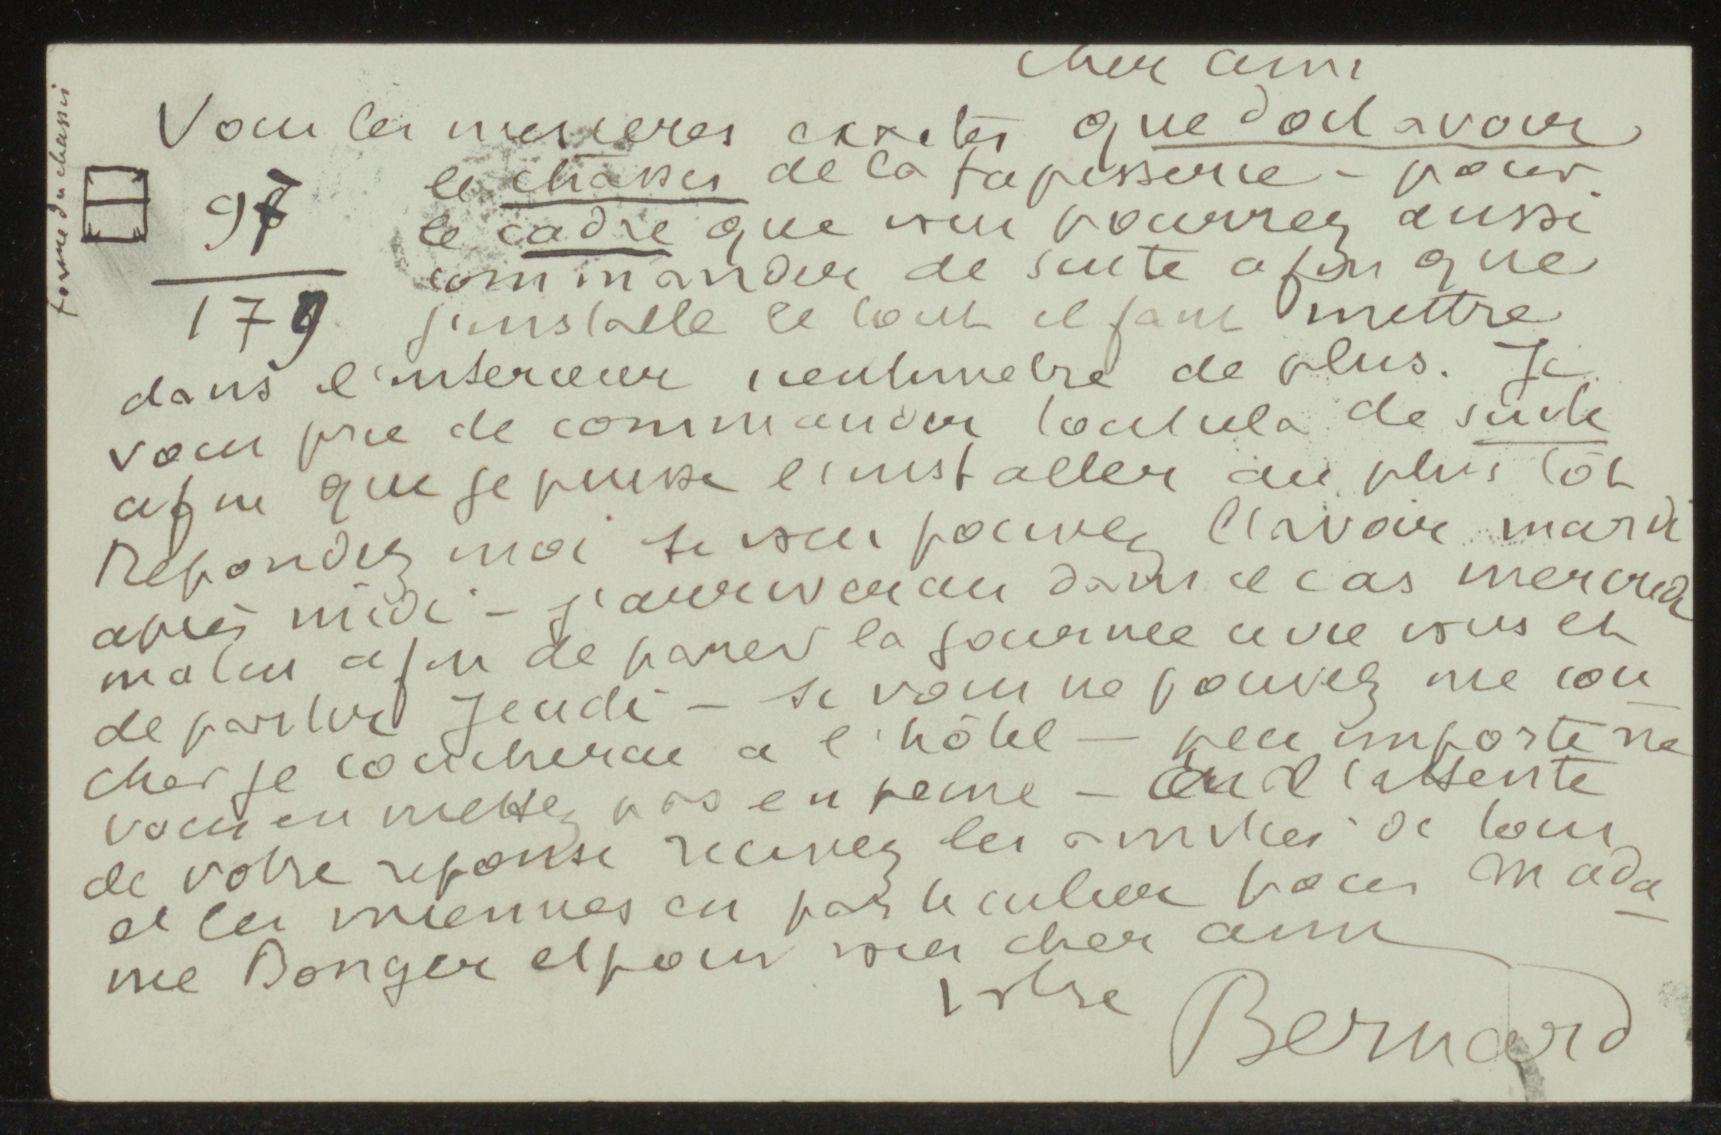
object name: postcard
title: Briefkaart aan Andries Bonger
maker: émile bernard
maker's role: print maker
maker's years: 1868-1941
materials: cardboard, ink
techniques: pen, writing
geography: laren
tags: amsterdam, andries bonger, applied arts, arts and crafts; industrial design